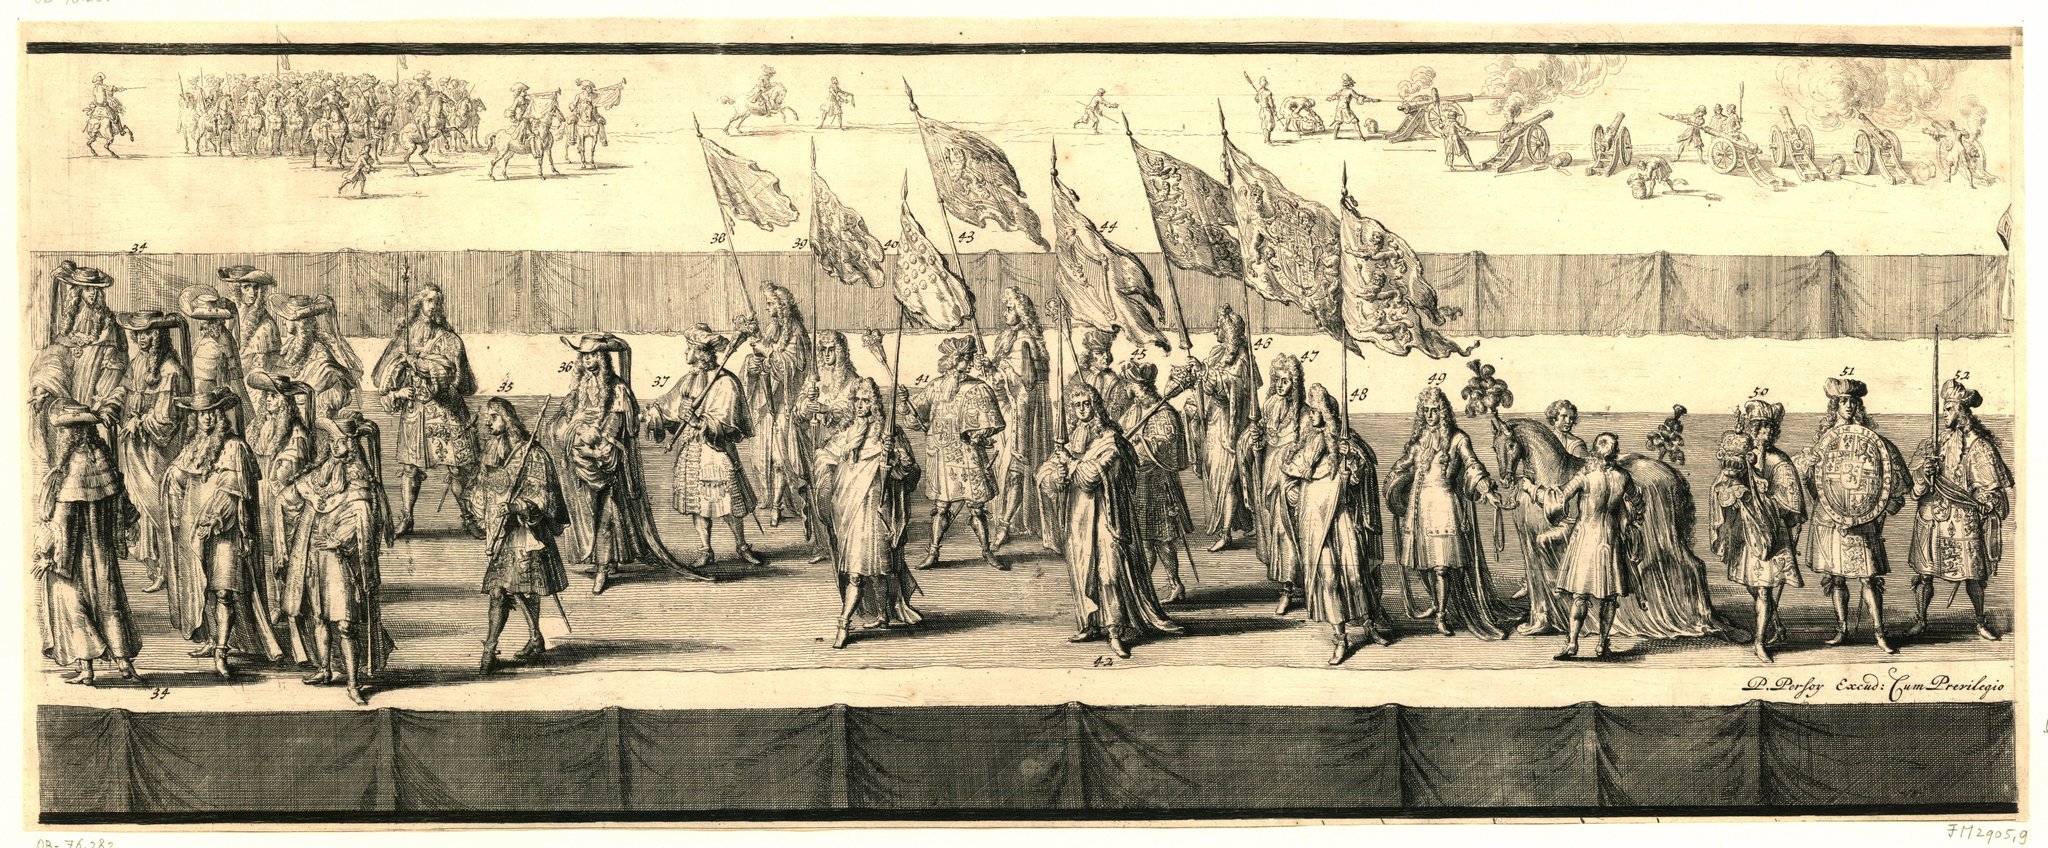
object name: print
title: De lijkstatie van de koningin, tweede deel, tweede helft, 1695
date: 1695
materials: paper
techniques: etching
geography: northern netherlands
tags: london, maria ii stuart (koningin van engeland, schotland en ierland), cortege, funeral procession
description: De lijkstatie van de koningin, rechter helft van de tweede plaat. Het deel van de stoet met de leden van het Hogerhuis en de banieren. Elementen in de prent zijn genummerd 34-52. De prent is als illustratie gebruikt in Samuel Gruterus, Funeralia Mariae II Britanniarum, Haarlem 1695.